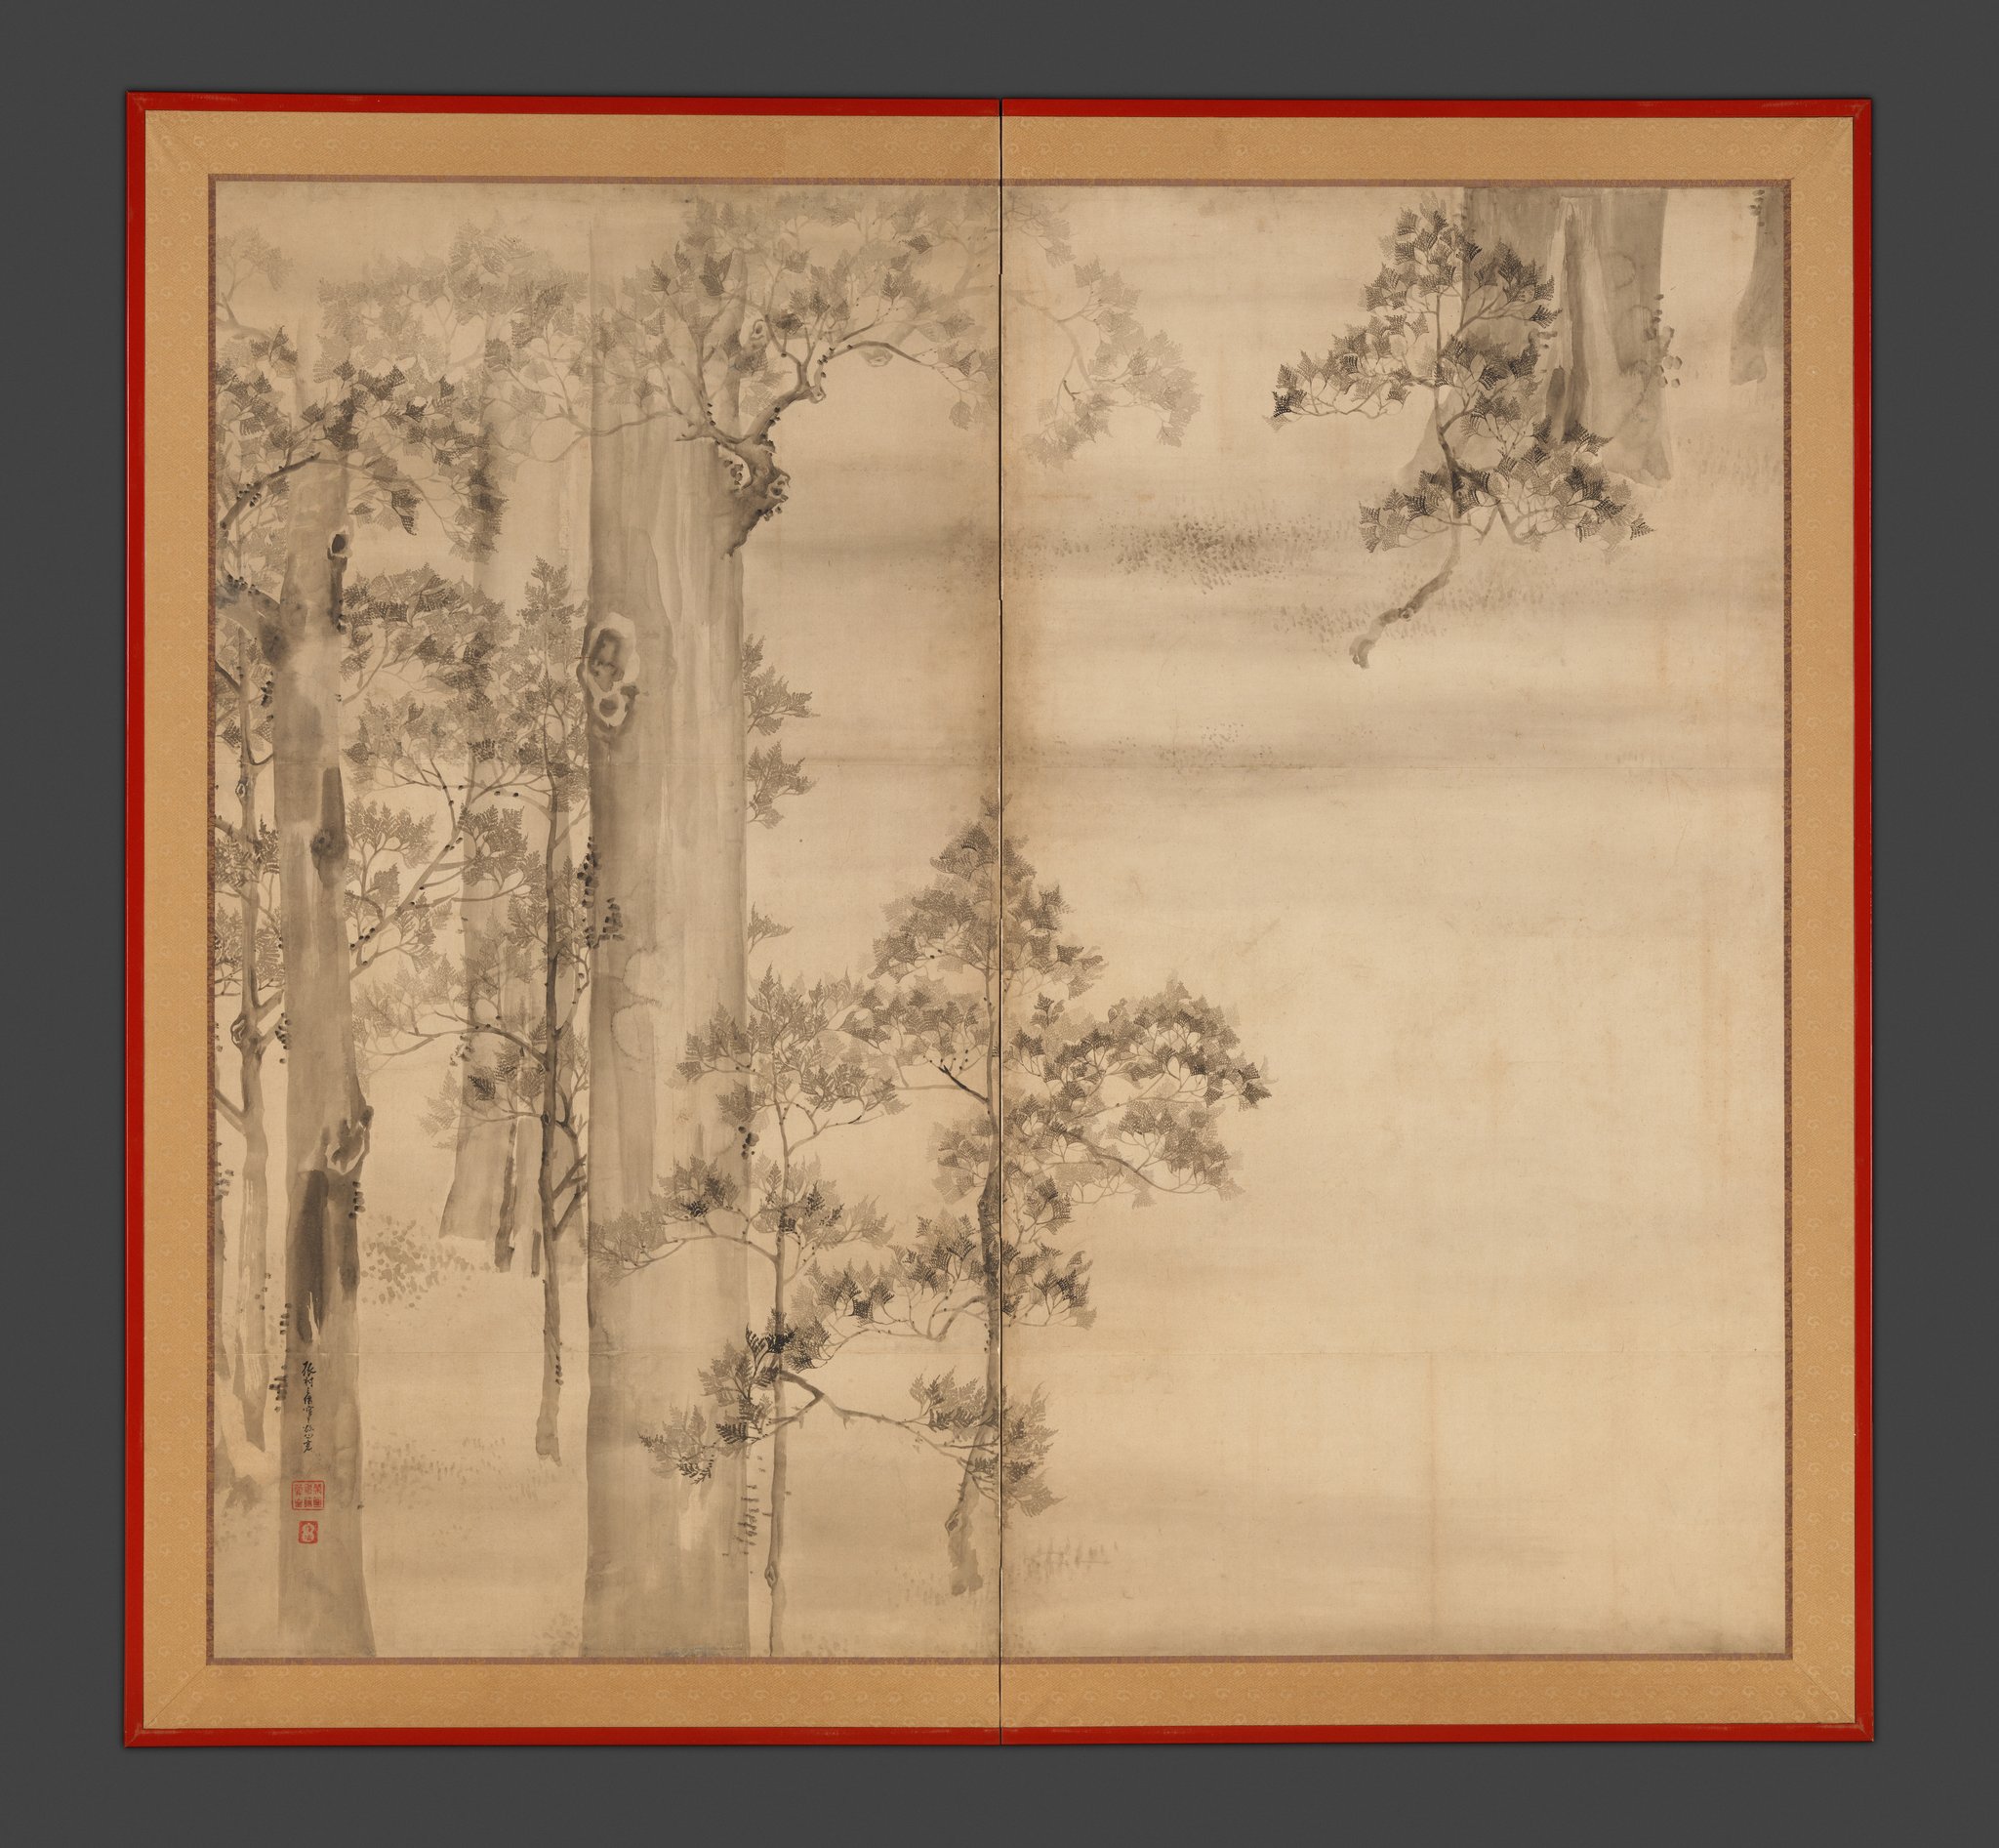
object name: screen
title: Cypresses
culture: japanese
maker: ikeda koson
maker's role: artist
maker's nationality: japanese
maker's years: 1803-1868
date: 1834-1866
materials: ink, panel, paper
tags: cypresses